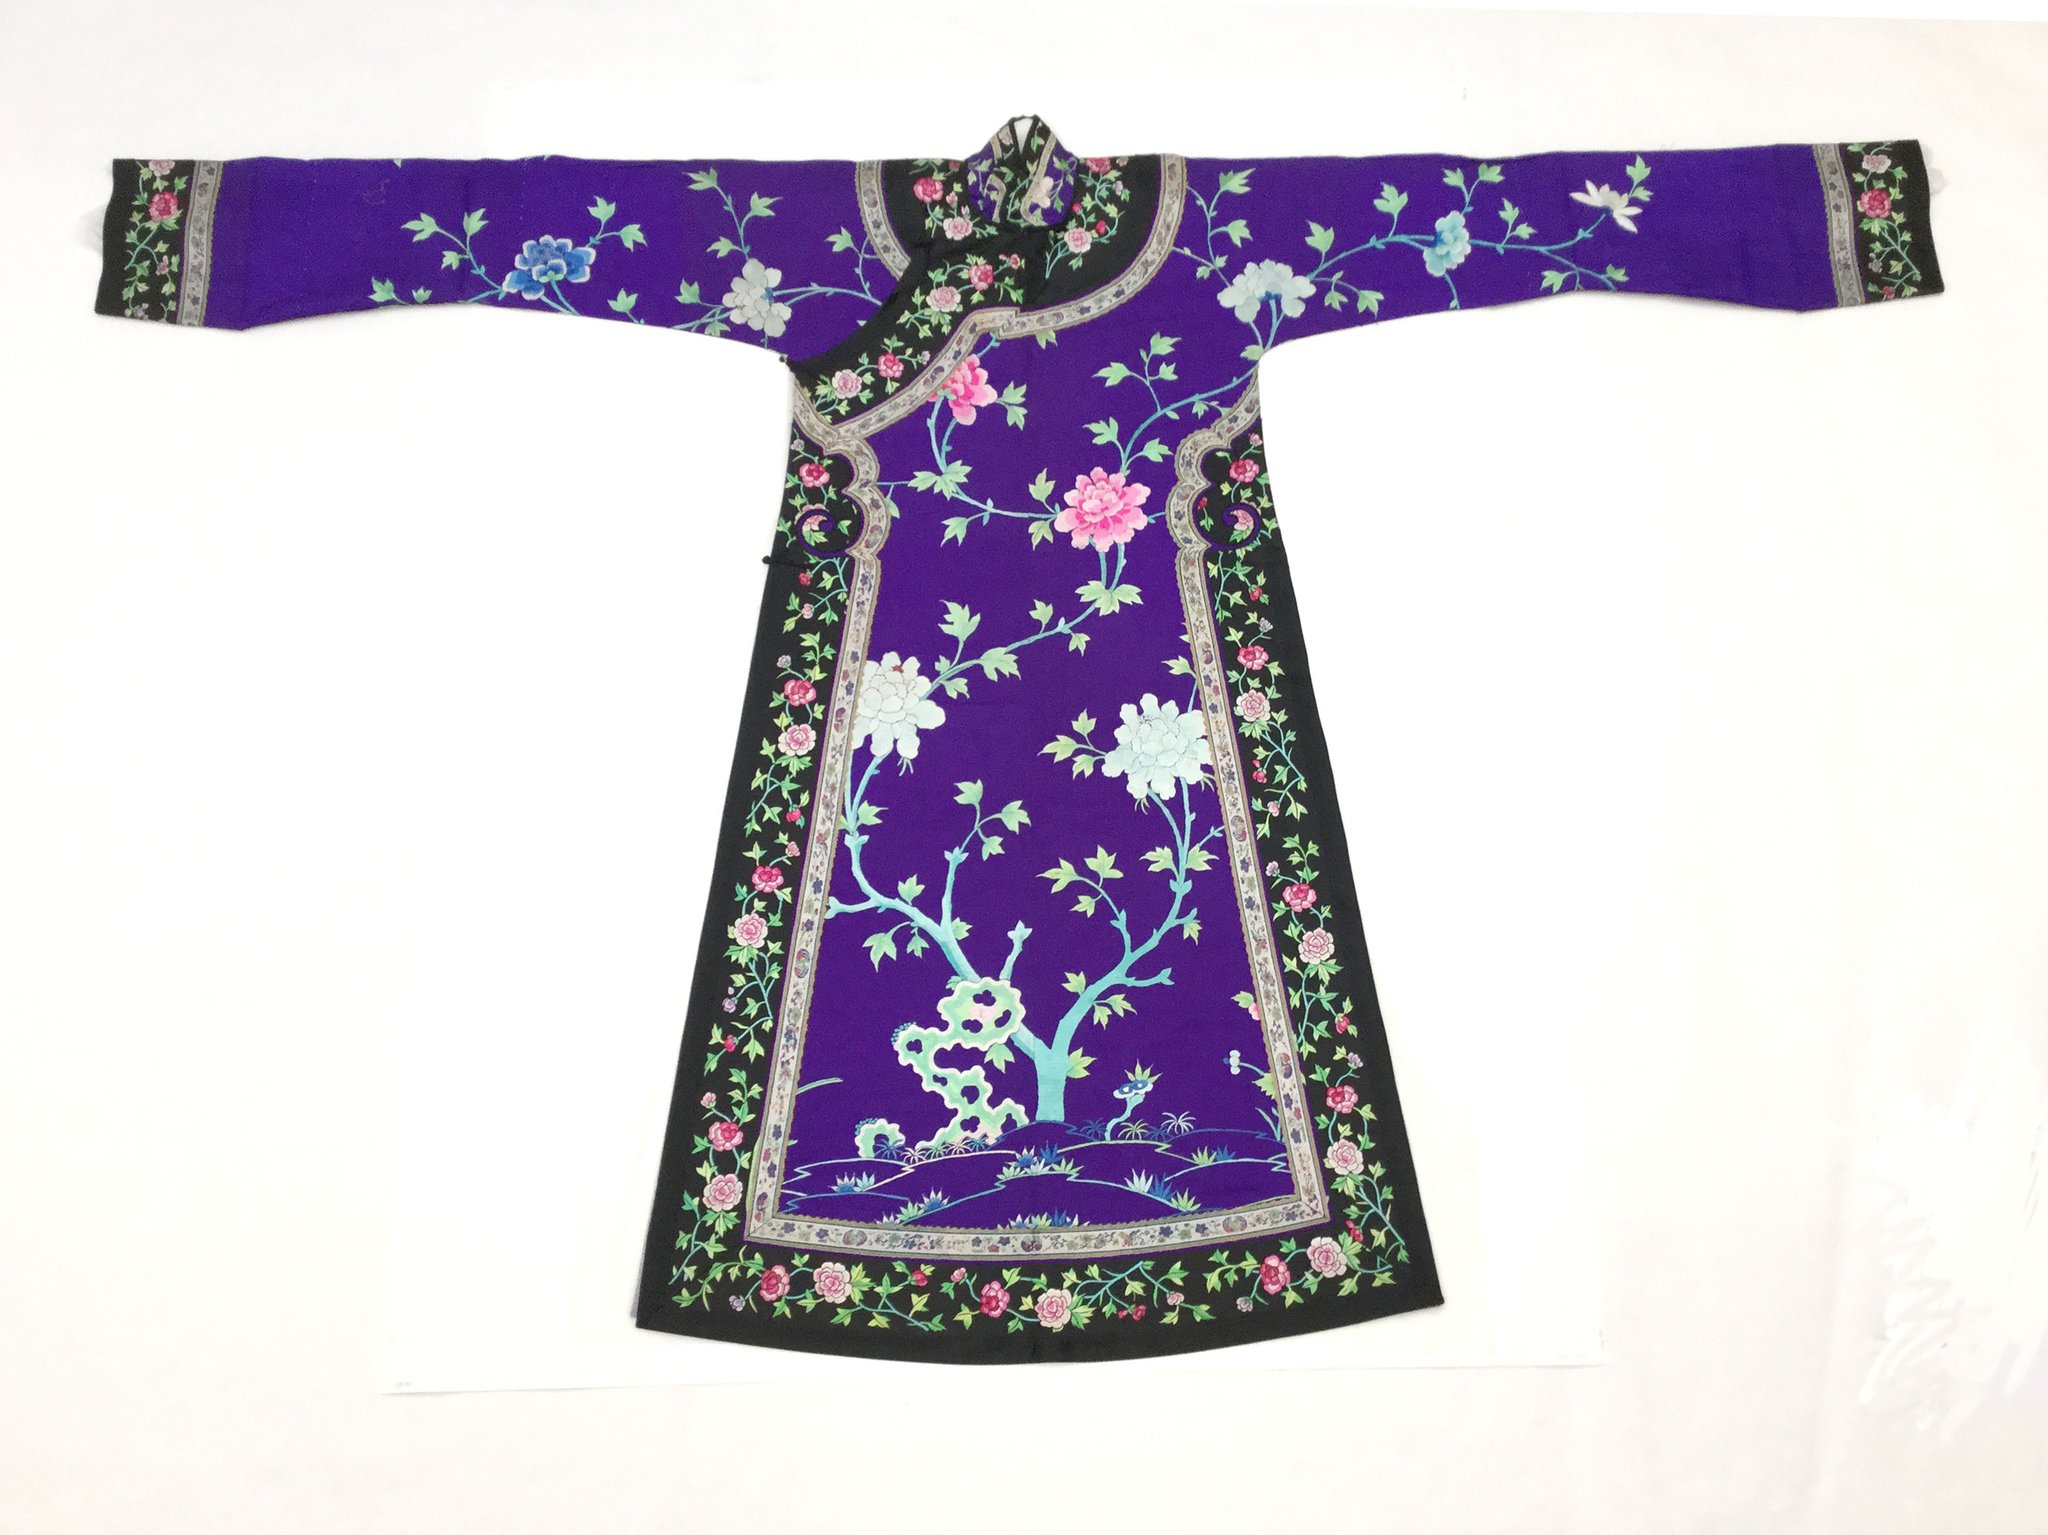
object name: woman's informal robe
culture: chinese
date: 1867-1933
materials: silk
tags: flowers